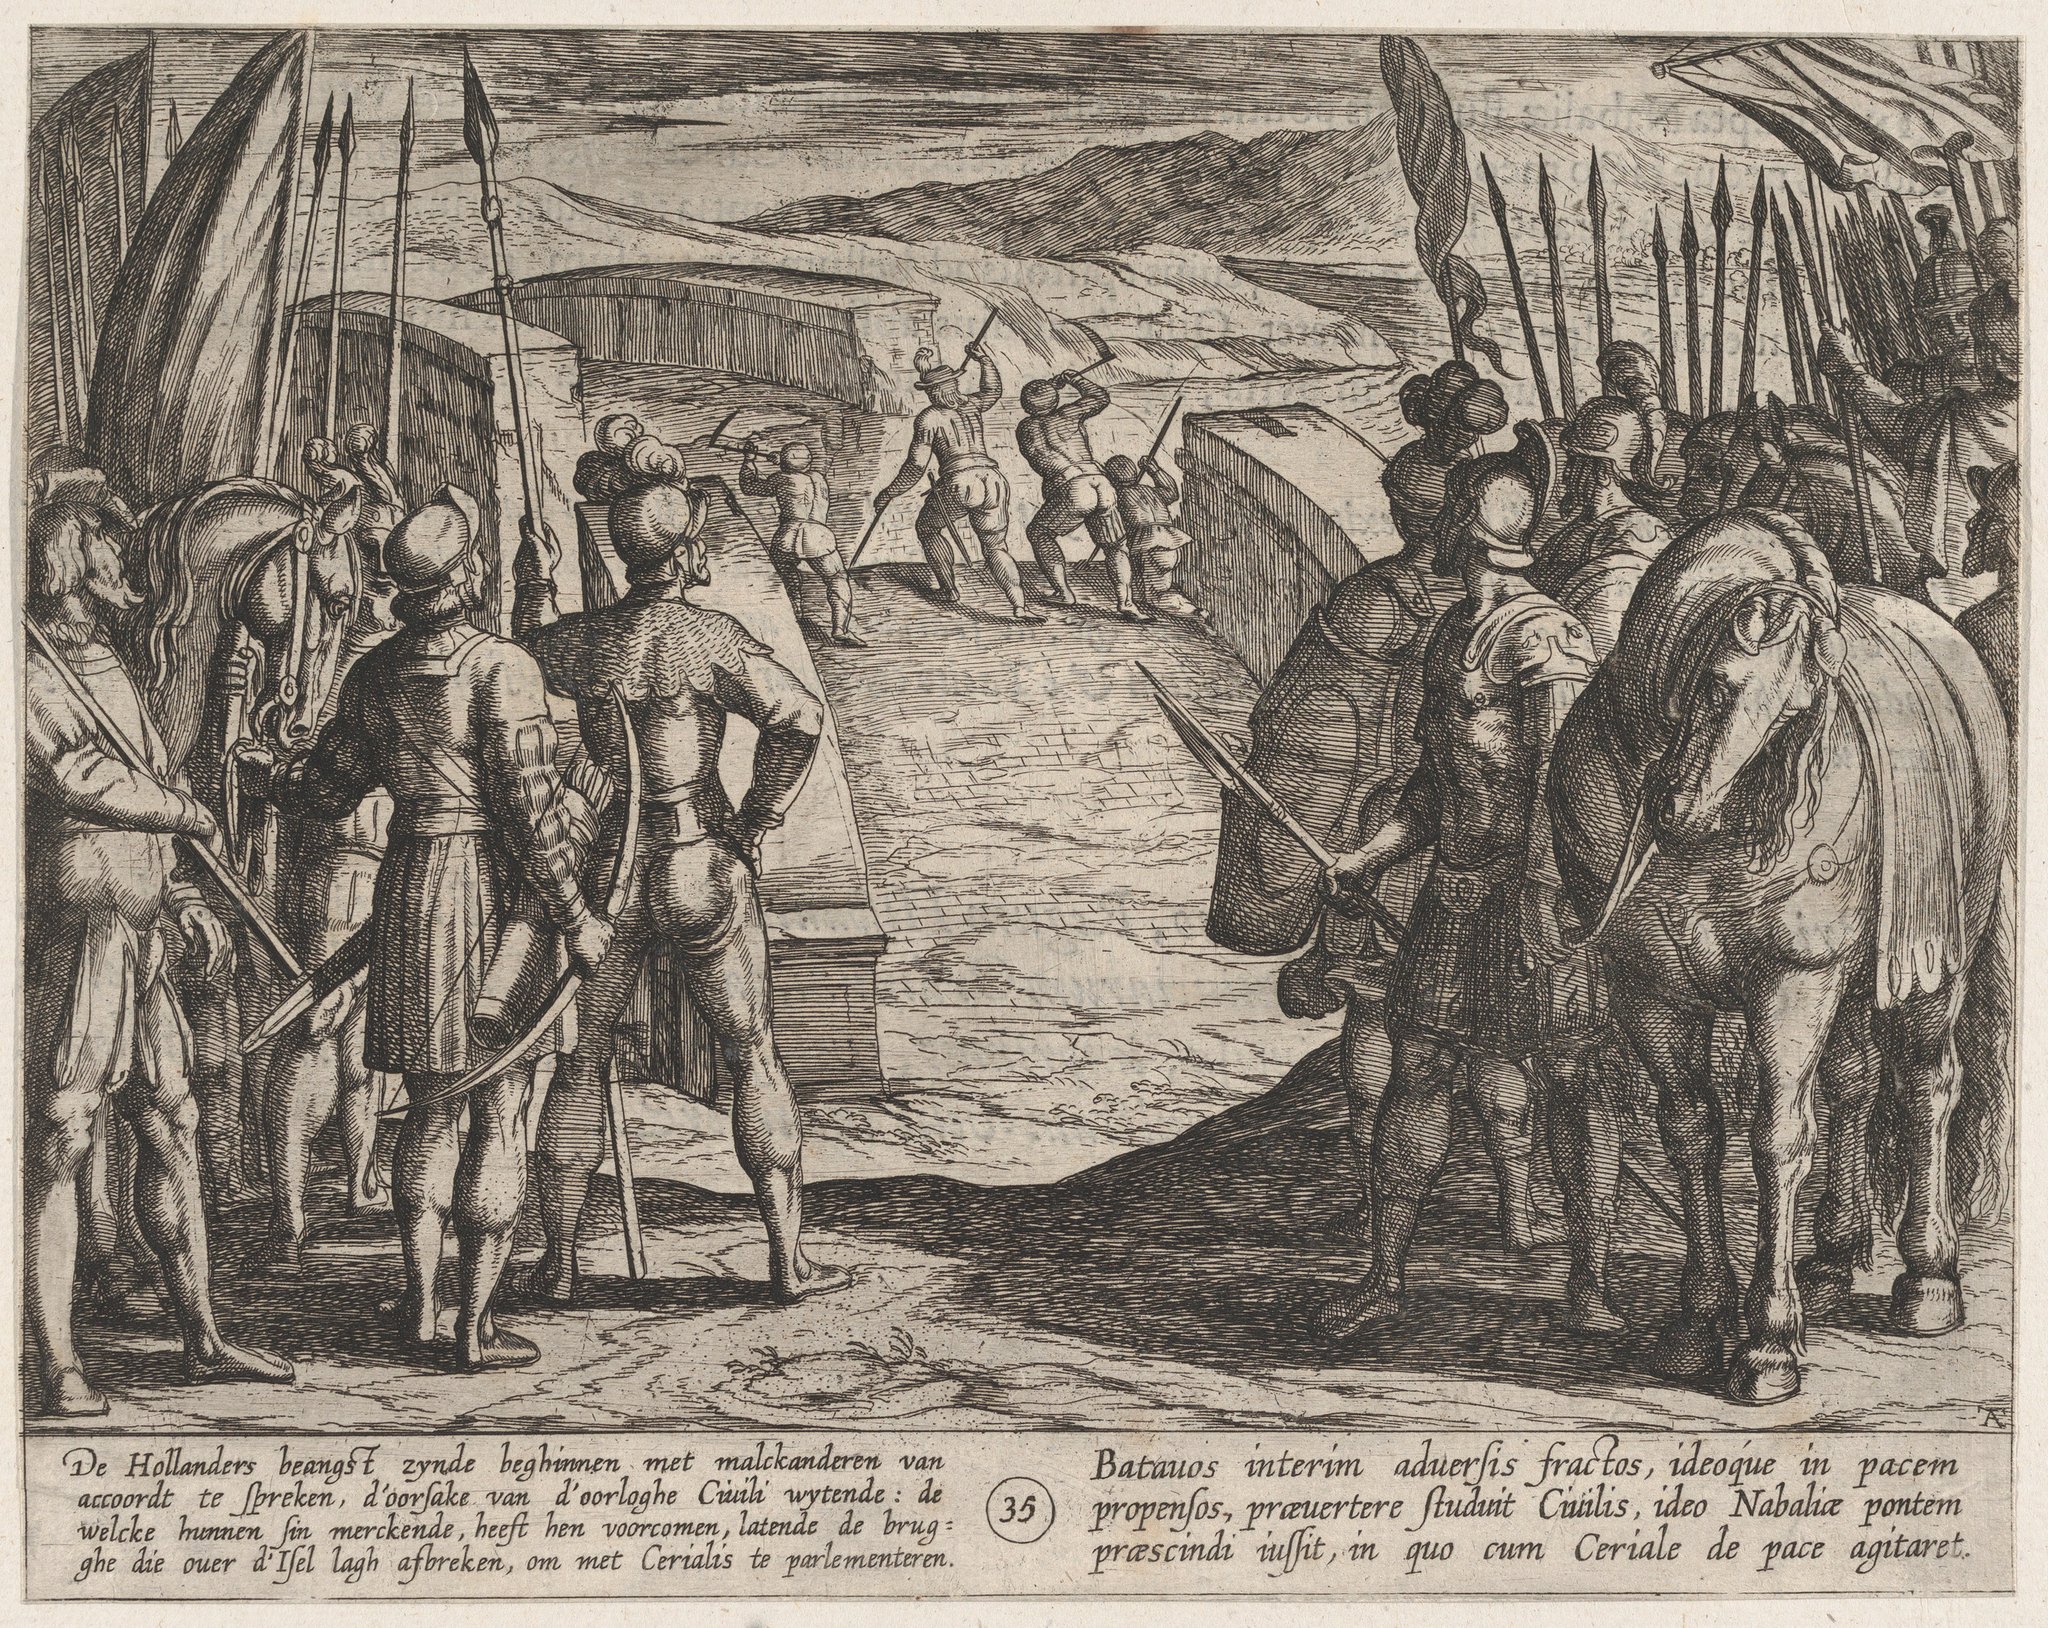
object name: print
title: Plate 35: The Batavians Become Afraid and Begin Peace Talks, from The War of the Romans Against the Batavians (Romanorvm et Batavorvm Societas)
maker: antonio tempesta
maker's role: artist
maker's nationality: italian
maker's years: 1555-1630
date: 1611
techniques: etching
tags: wars,weapons,men,horses